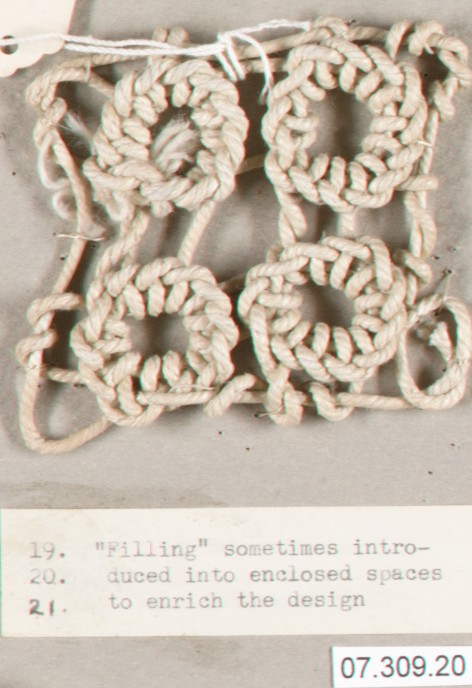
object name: stitch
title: Example of lace stitch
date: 1801-2000